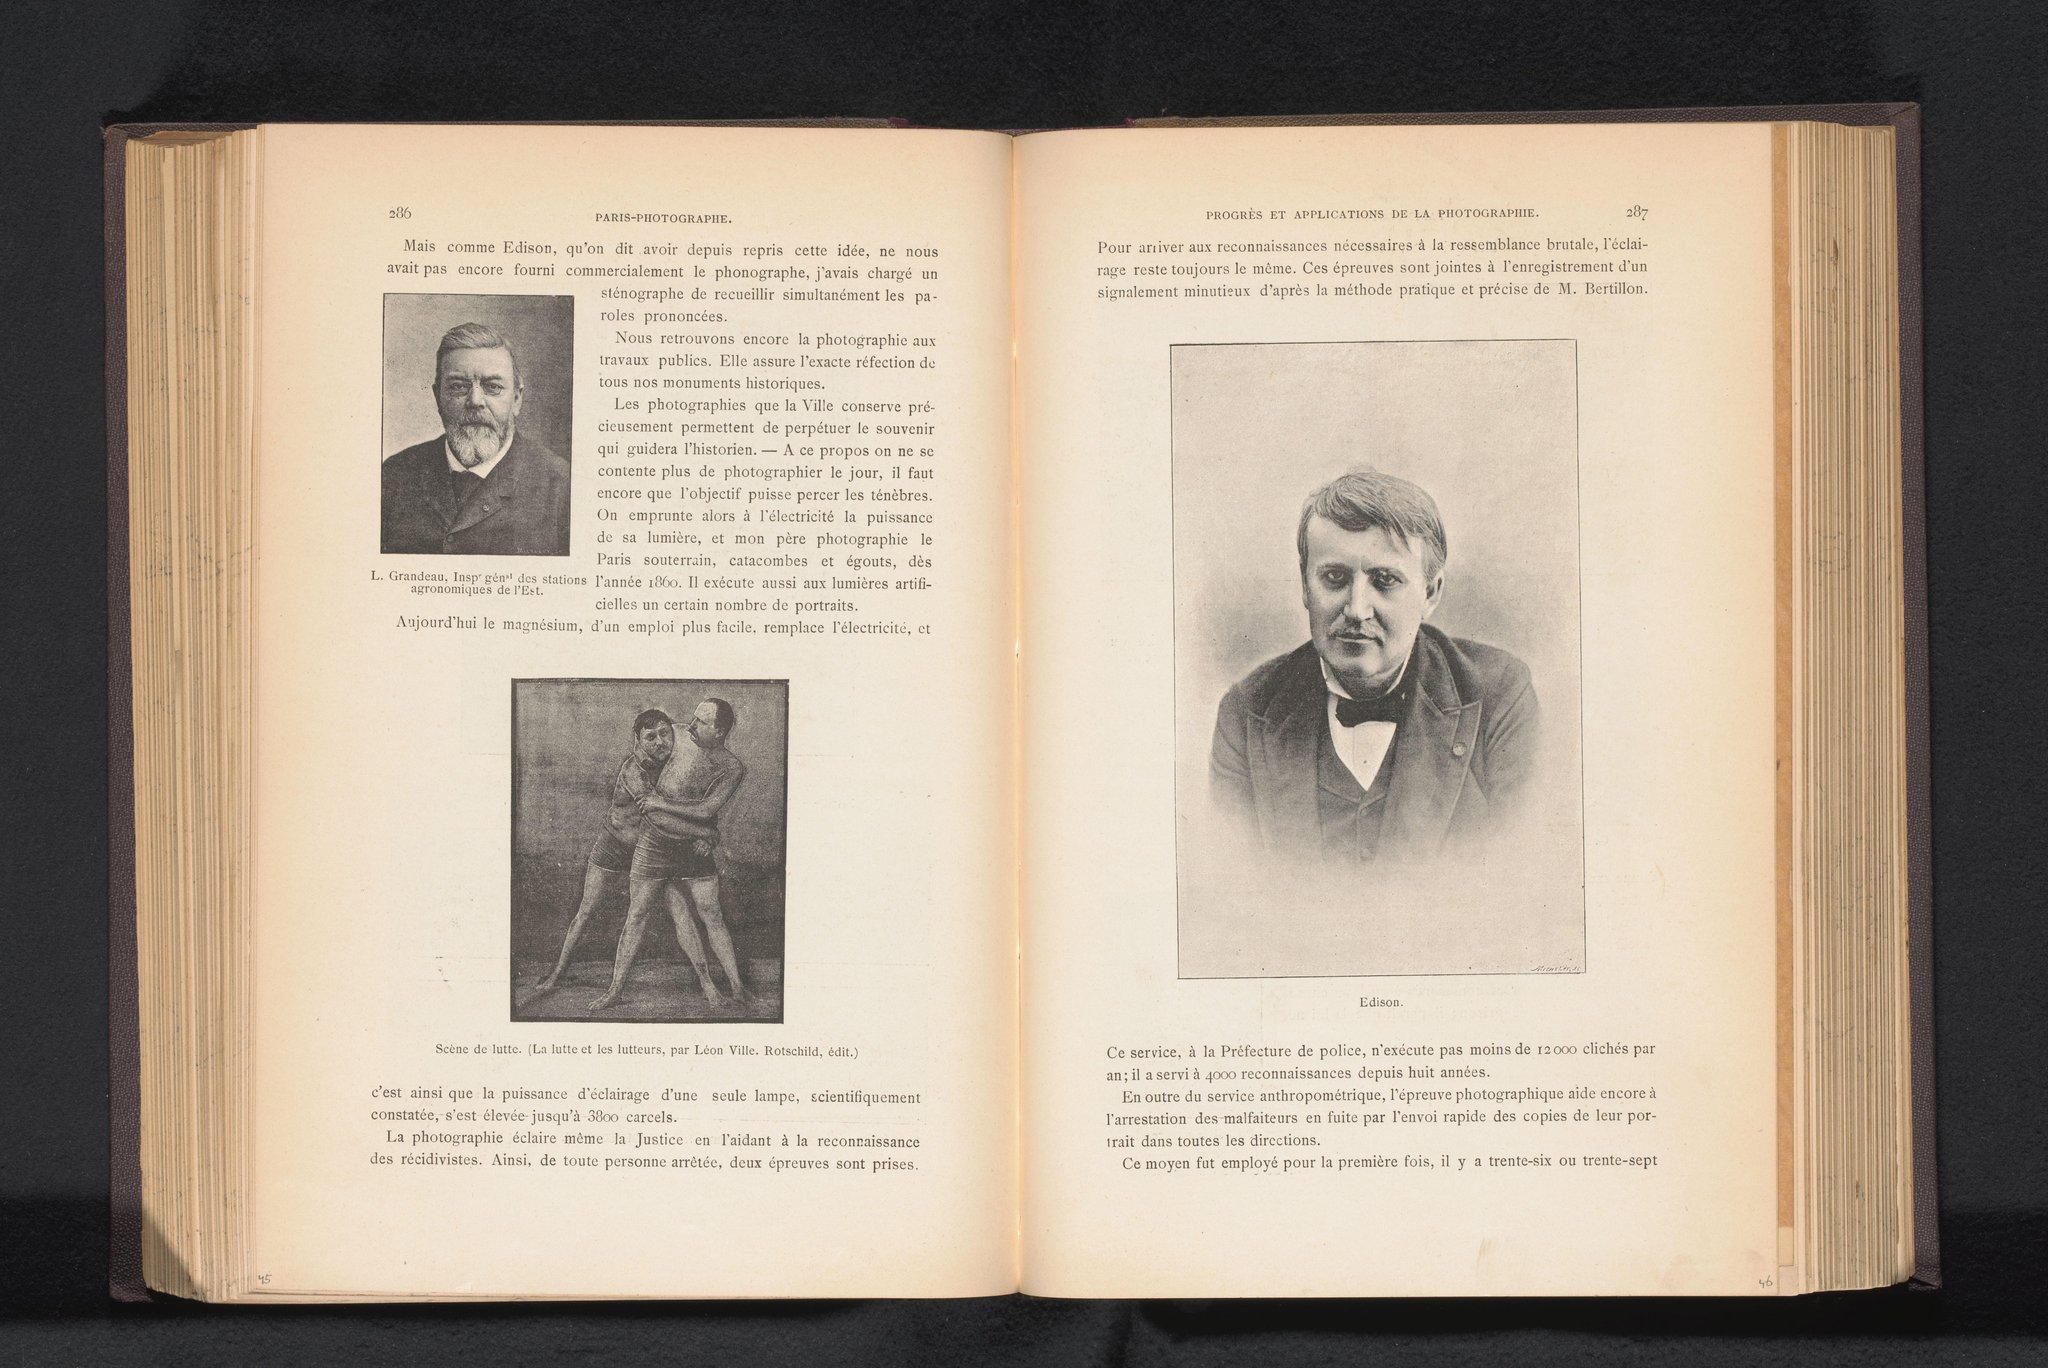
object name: page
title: Fotoreproductie van vermoedelijk een portret van Thomas Edison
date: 1882-1892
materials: paper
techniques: autotype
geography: france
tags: adult man